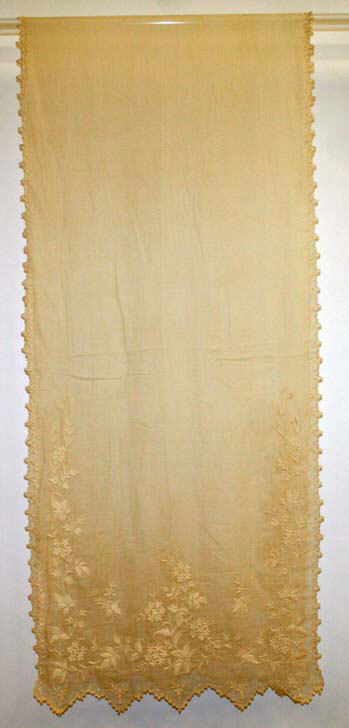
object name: fichu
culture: american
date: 1800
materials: cotton